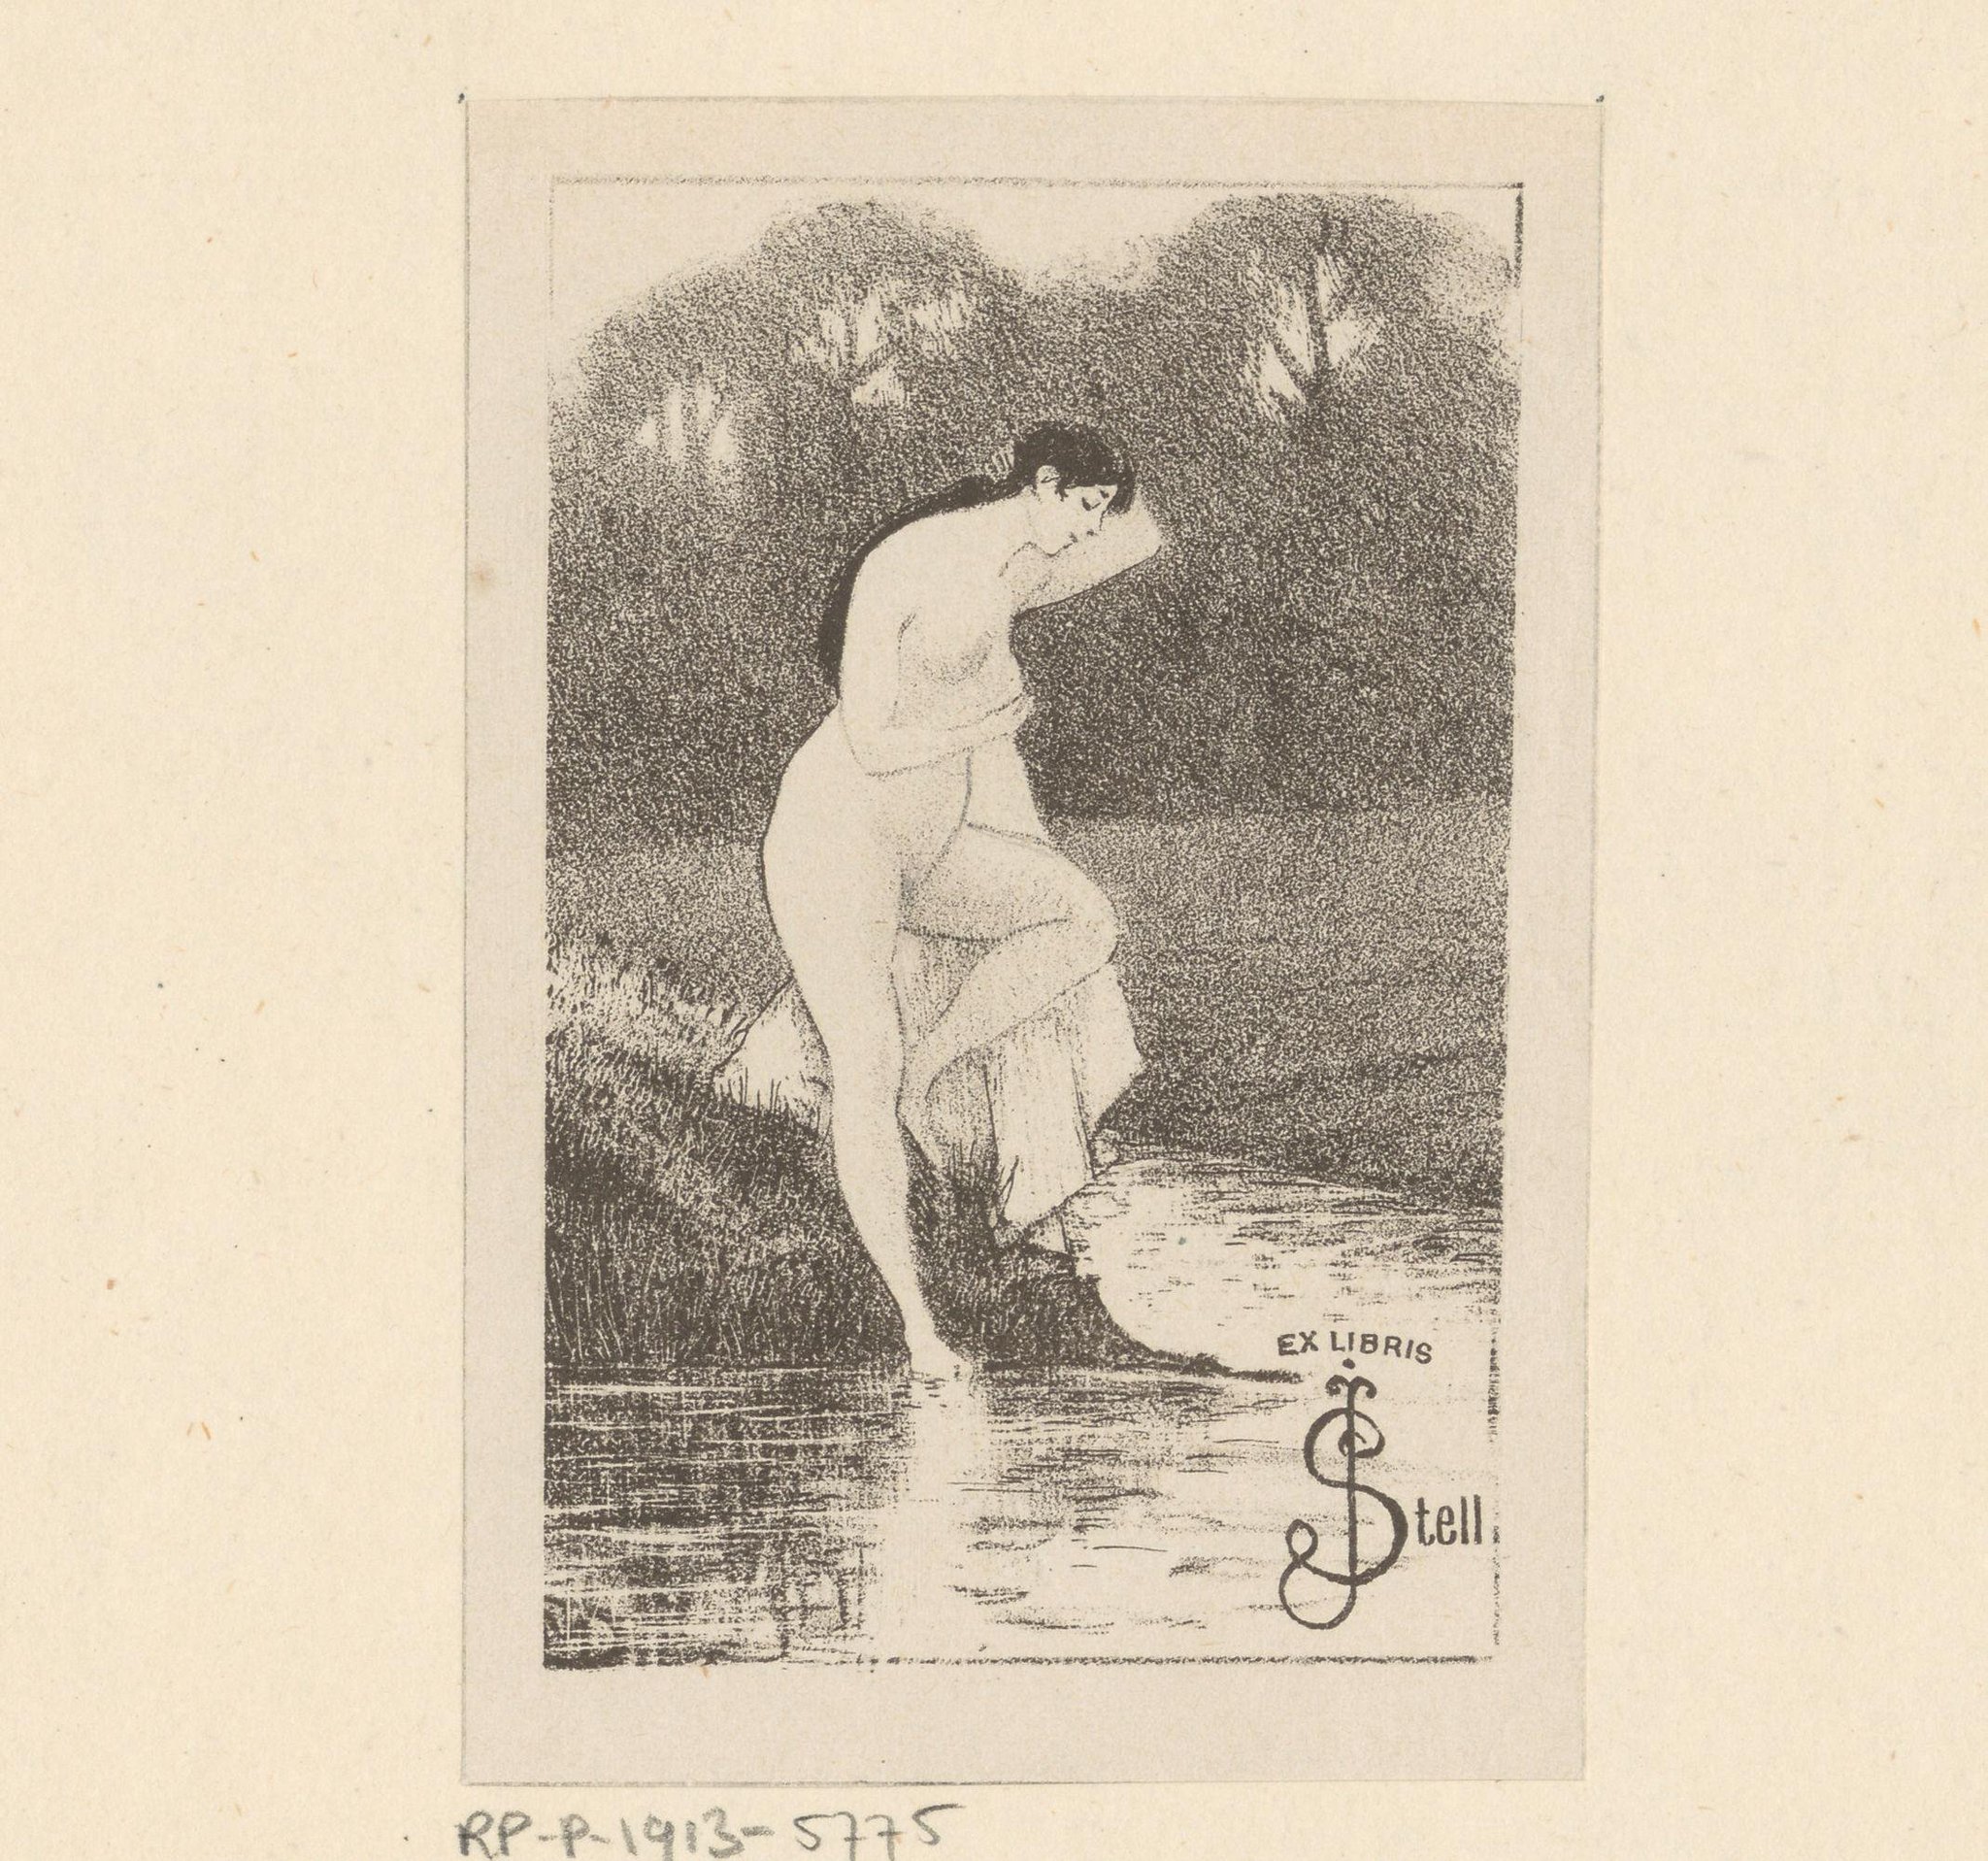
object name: bookplate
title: Ex libris van J. Stell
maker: Anonymous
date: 1880-1913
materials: paper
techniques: lithograph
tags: landscapes with waters, waterscapes, seascapes (in the temperate zone), woman (showing herself) undressed, quasi-nude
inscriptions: collector's mark: Lugt 2760, collector's mark: Lugt 2233